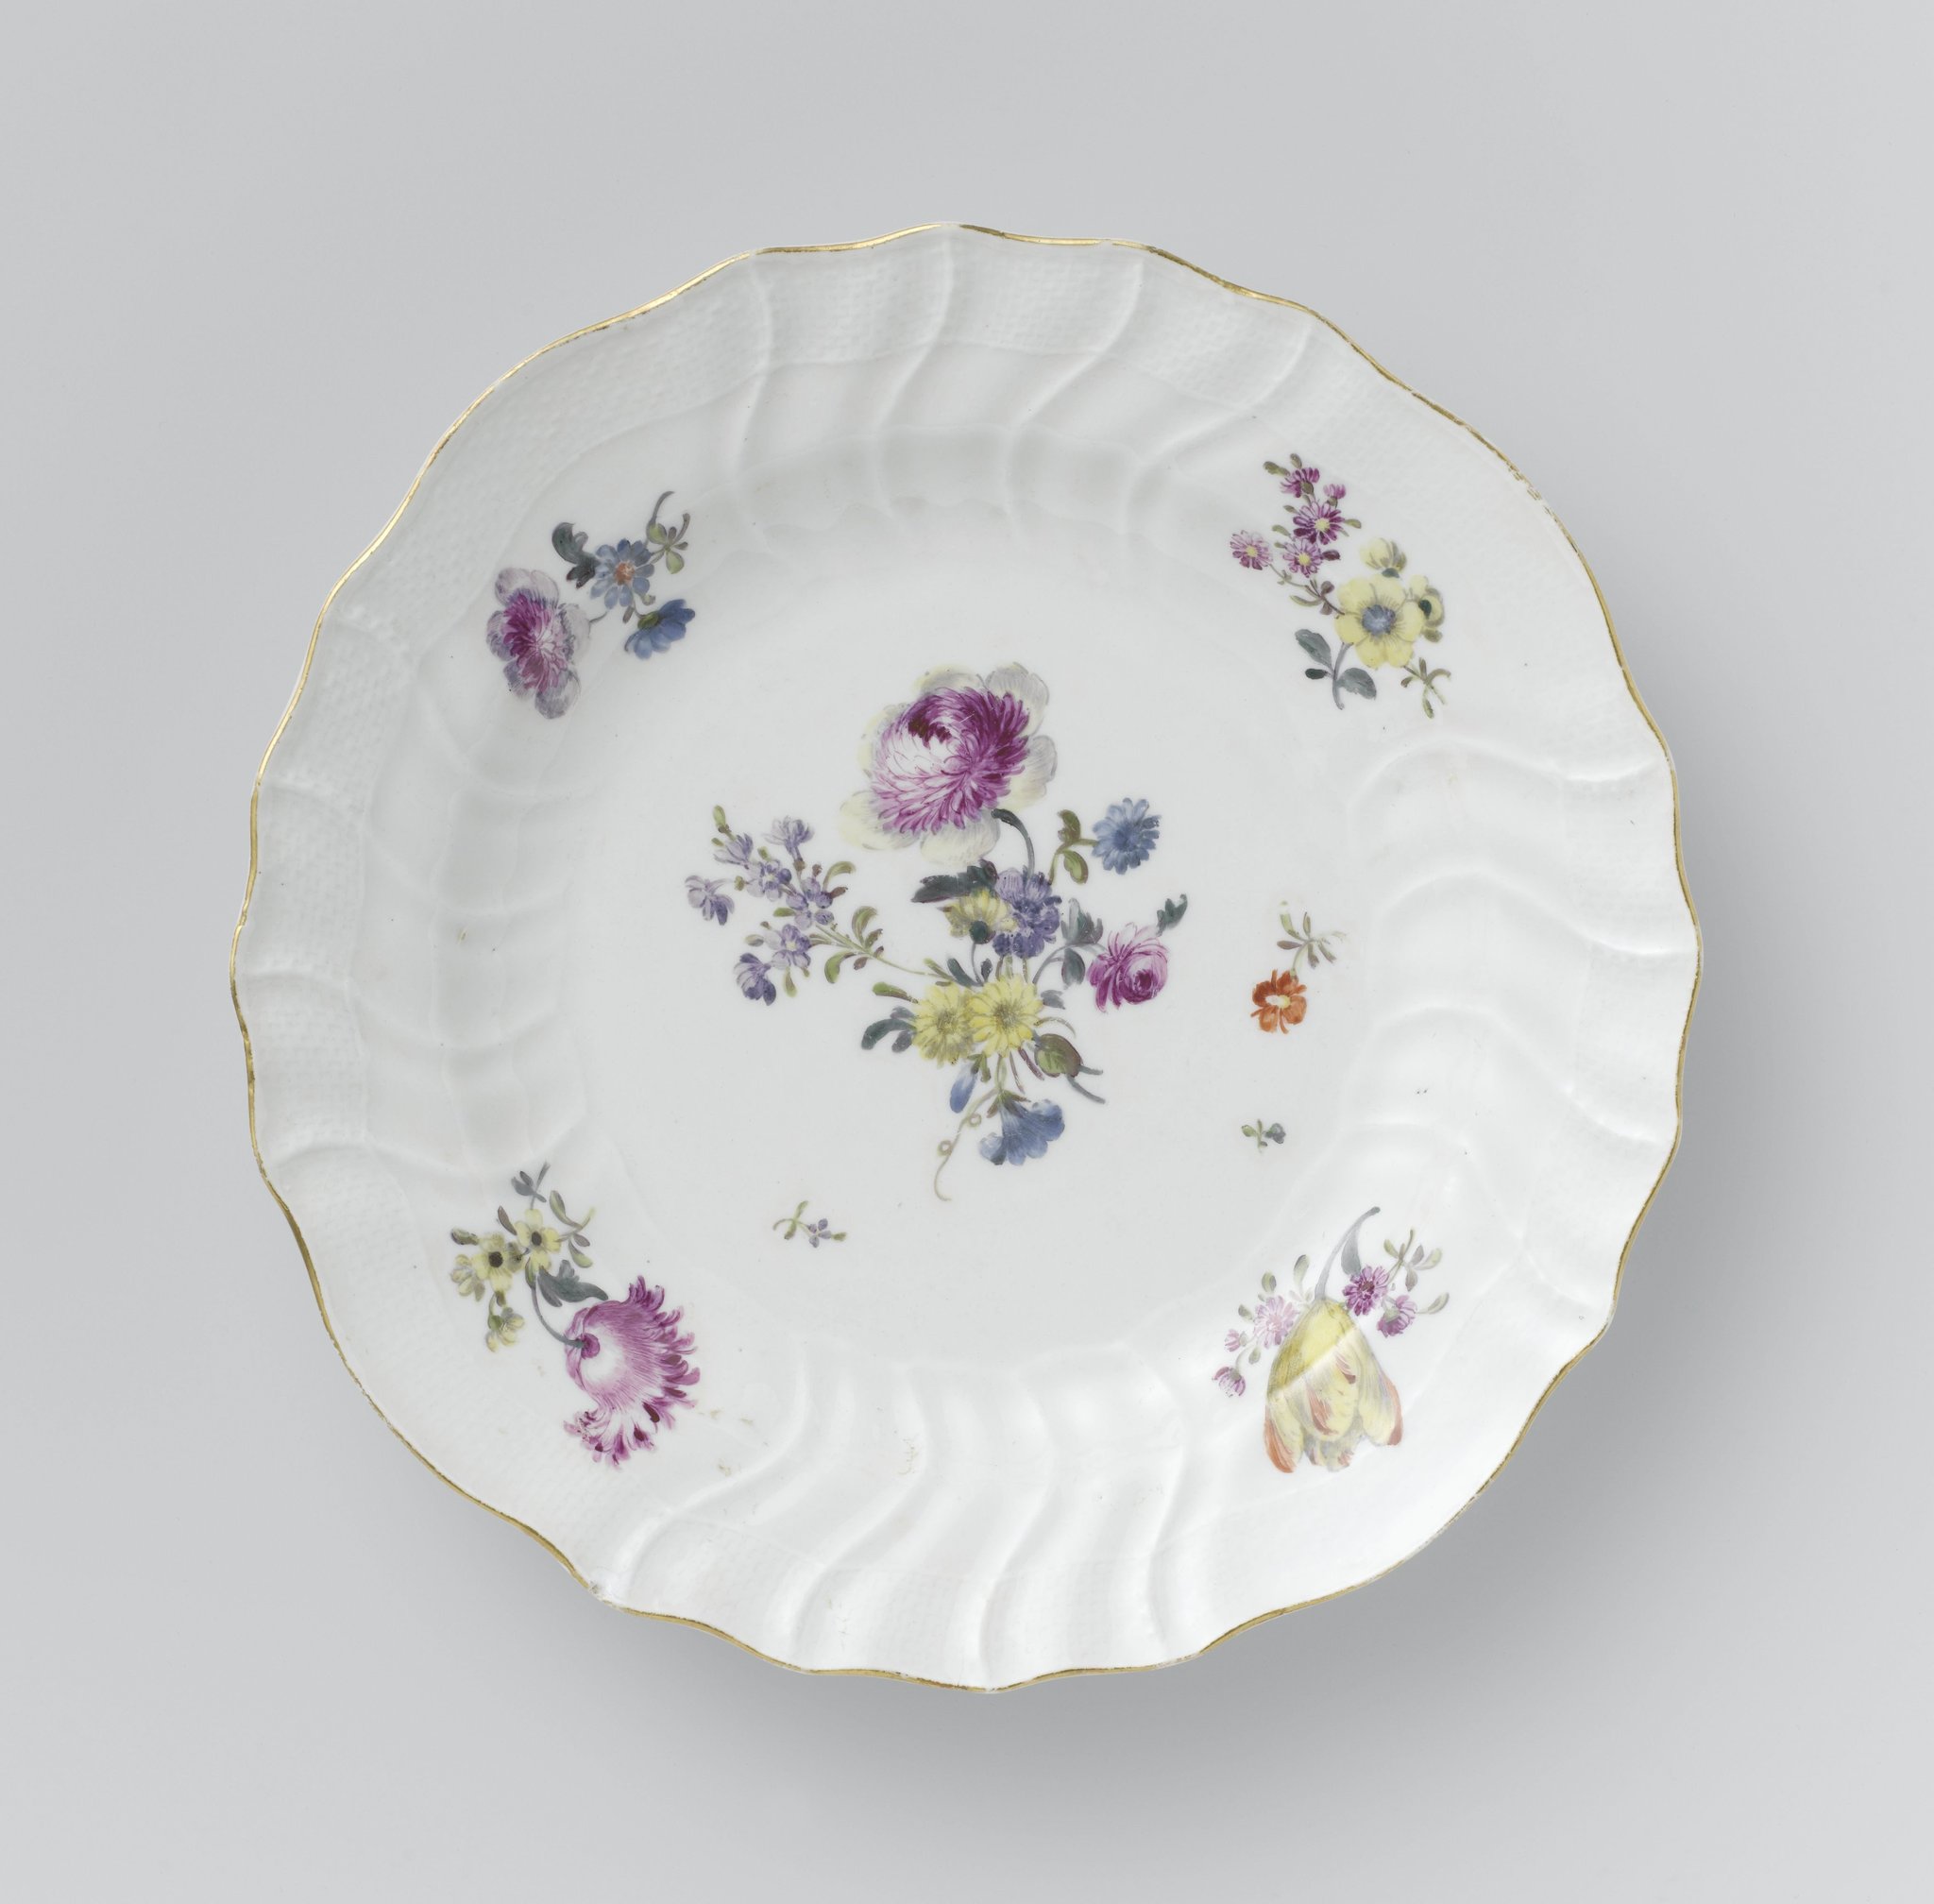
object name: plate dish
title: Bord, veelkleurig beschilderd met Deutsche Blumen, insekten en vruchten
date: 1750-1760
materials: porcelain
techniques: painted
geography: meissen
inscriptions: factory mark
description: Rond bord van beschilderd porselein. De rand is versierd met het Neuozier-patroon. De beschildering bestaat uit Deutsche Blumen, insekten en vruchten. Het bord is gemerkt en hoort bij een servies (BK-17474-1 t/m BK-17474-253).